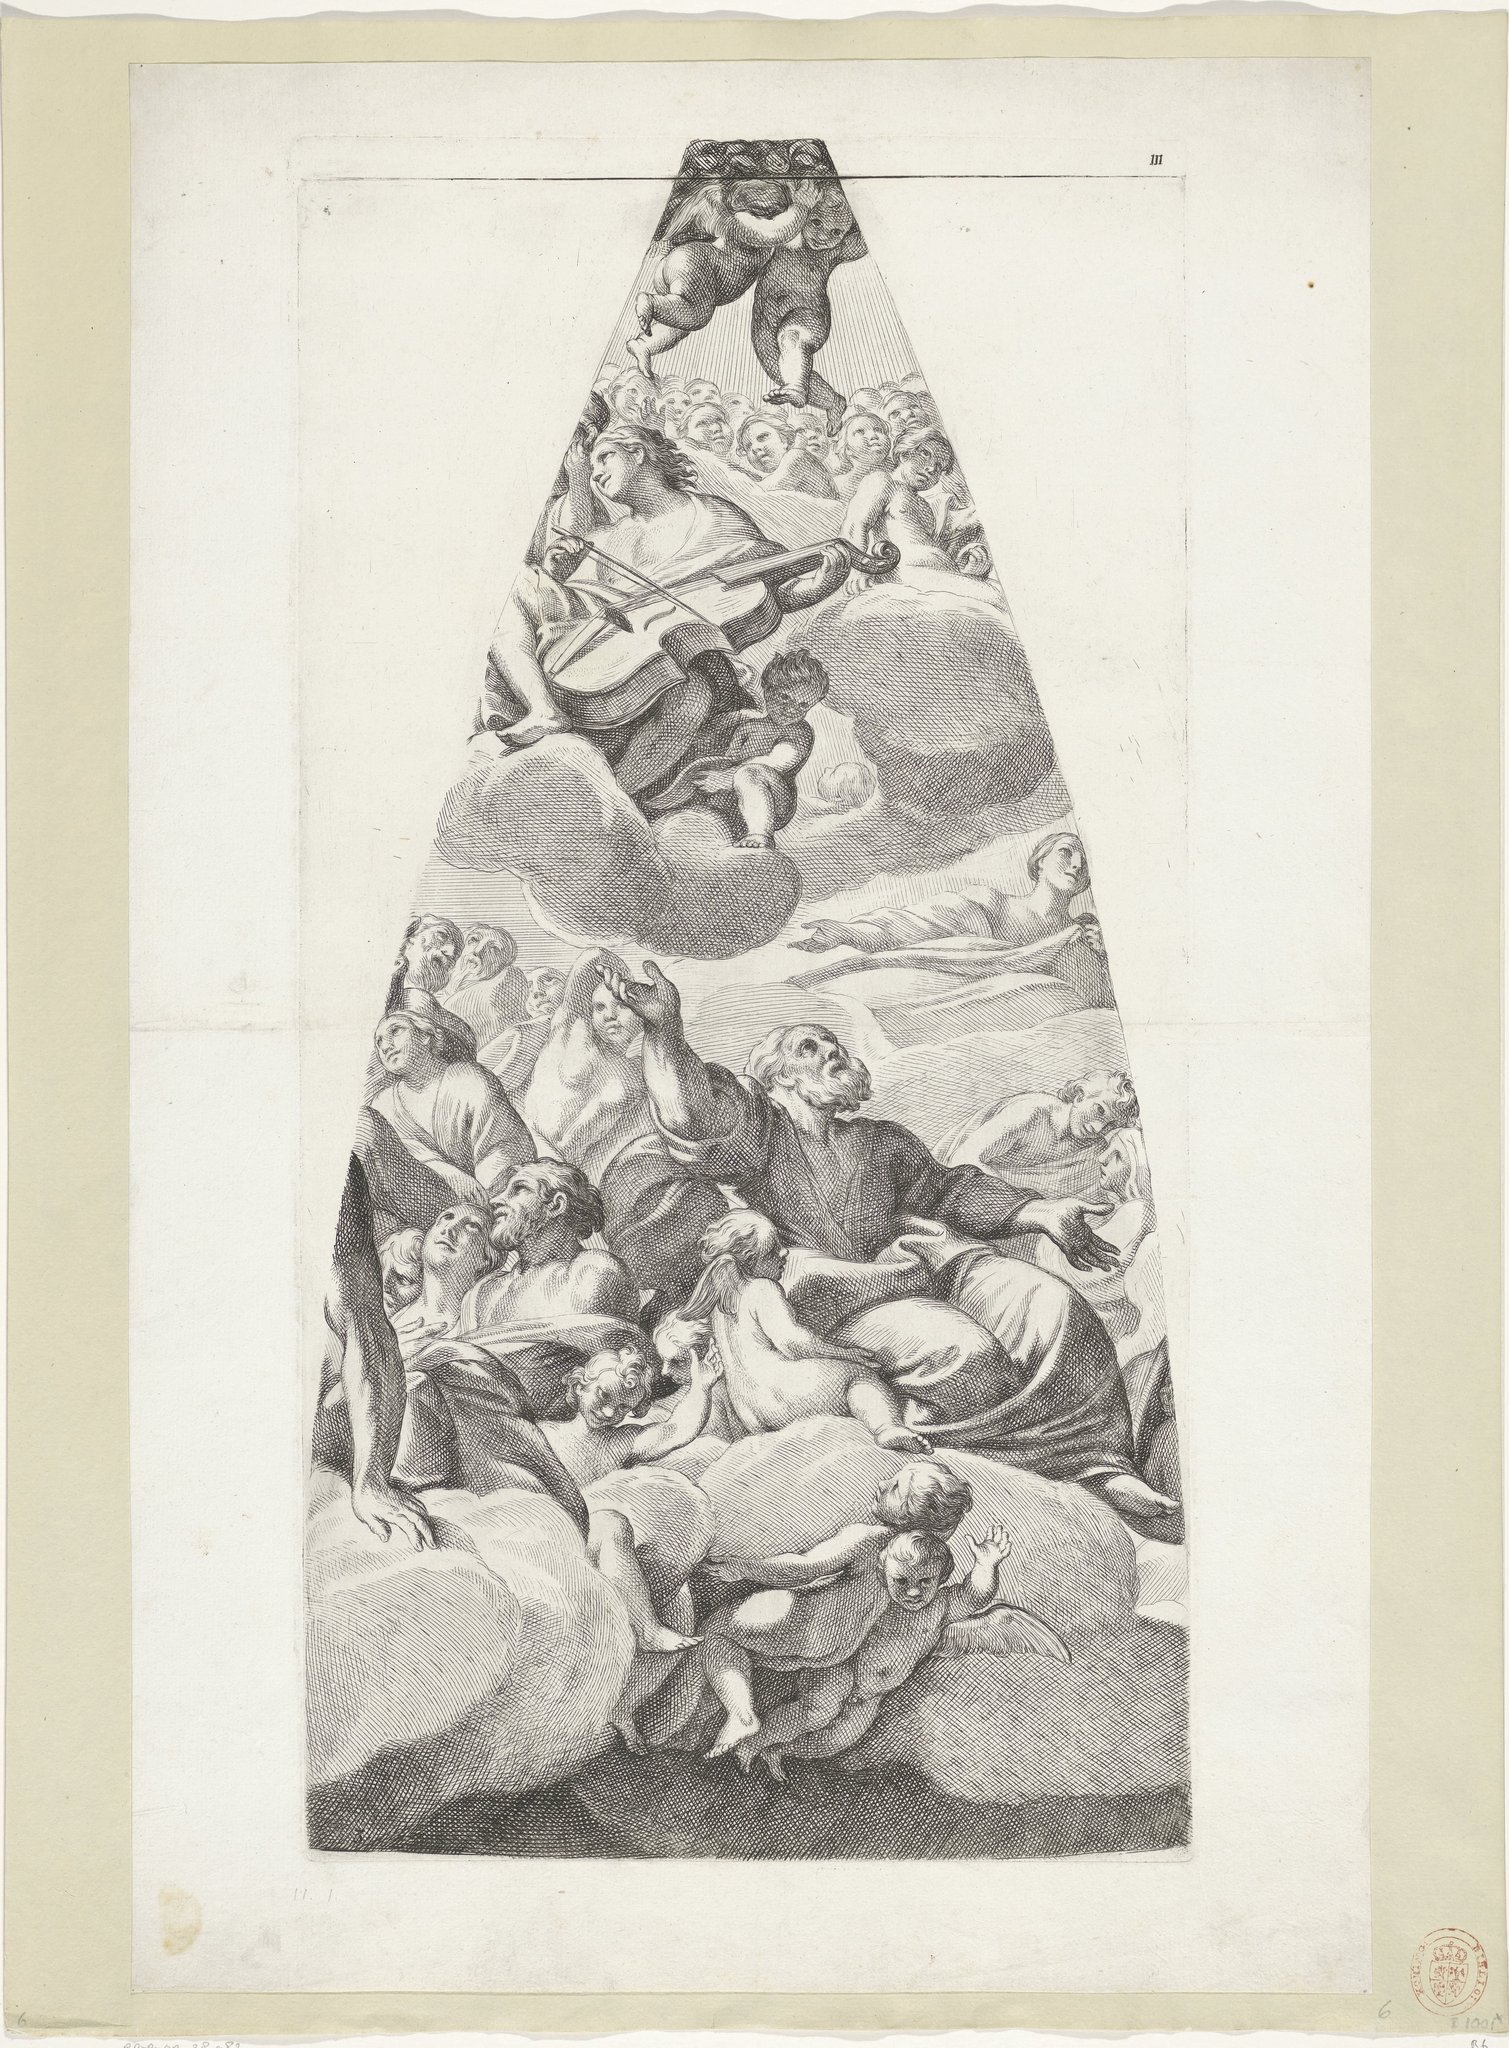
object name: print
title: De heilige Jozef en andere heilige met cellospelende engel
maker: carlo cesio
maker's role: painter, print maker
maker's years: 1622-1682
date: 1636-1686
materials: paper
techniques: engraving, etching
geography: italy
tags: angels singing, making music, saints, joseph (not in biblical context), angels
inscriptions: collector's mark: Lugt 240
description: Prent uit een reeks van 8 prenten naar de fresco's door Giovanni Lanfranco in de koepel van de San Andrea della Valle te Rome.